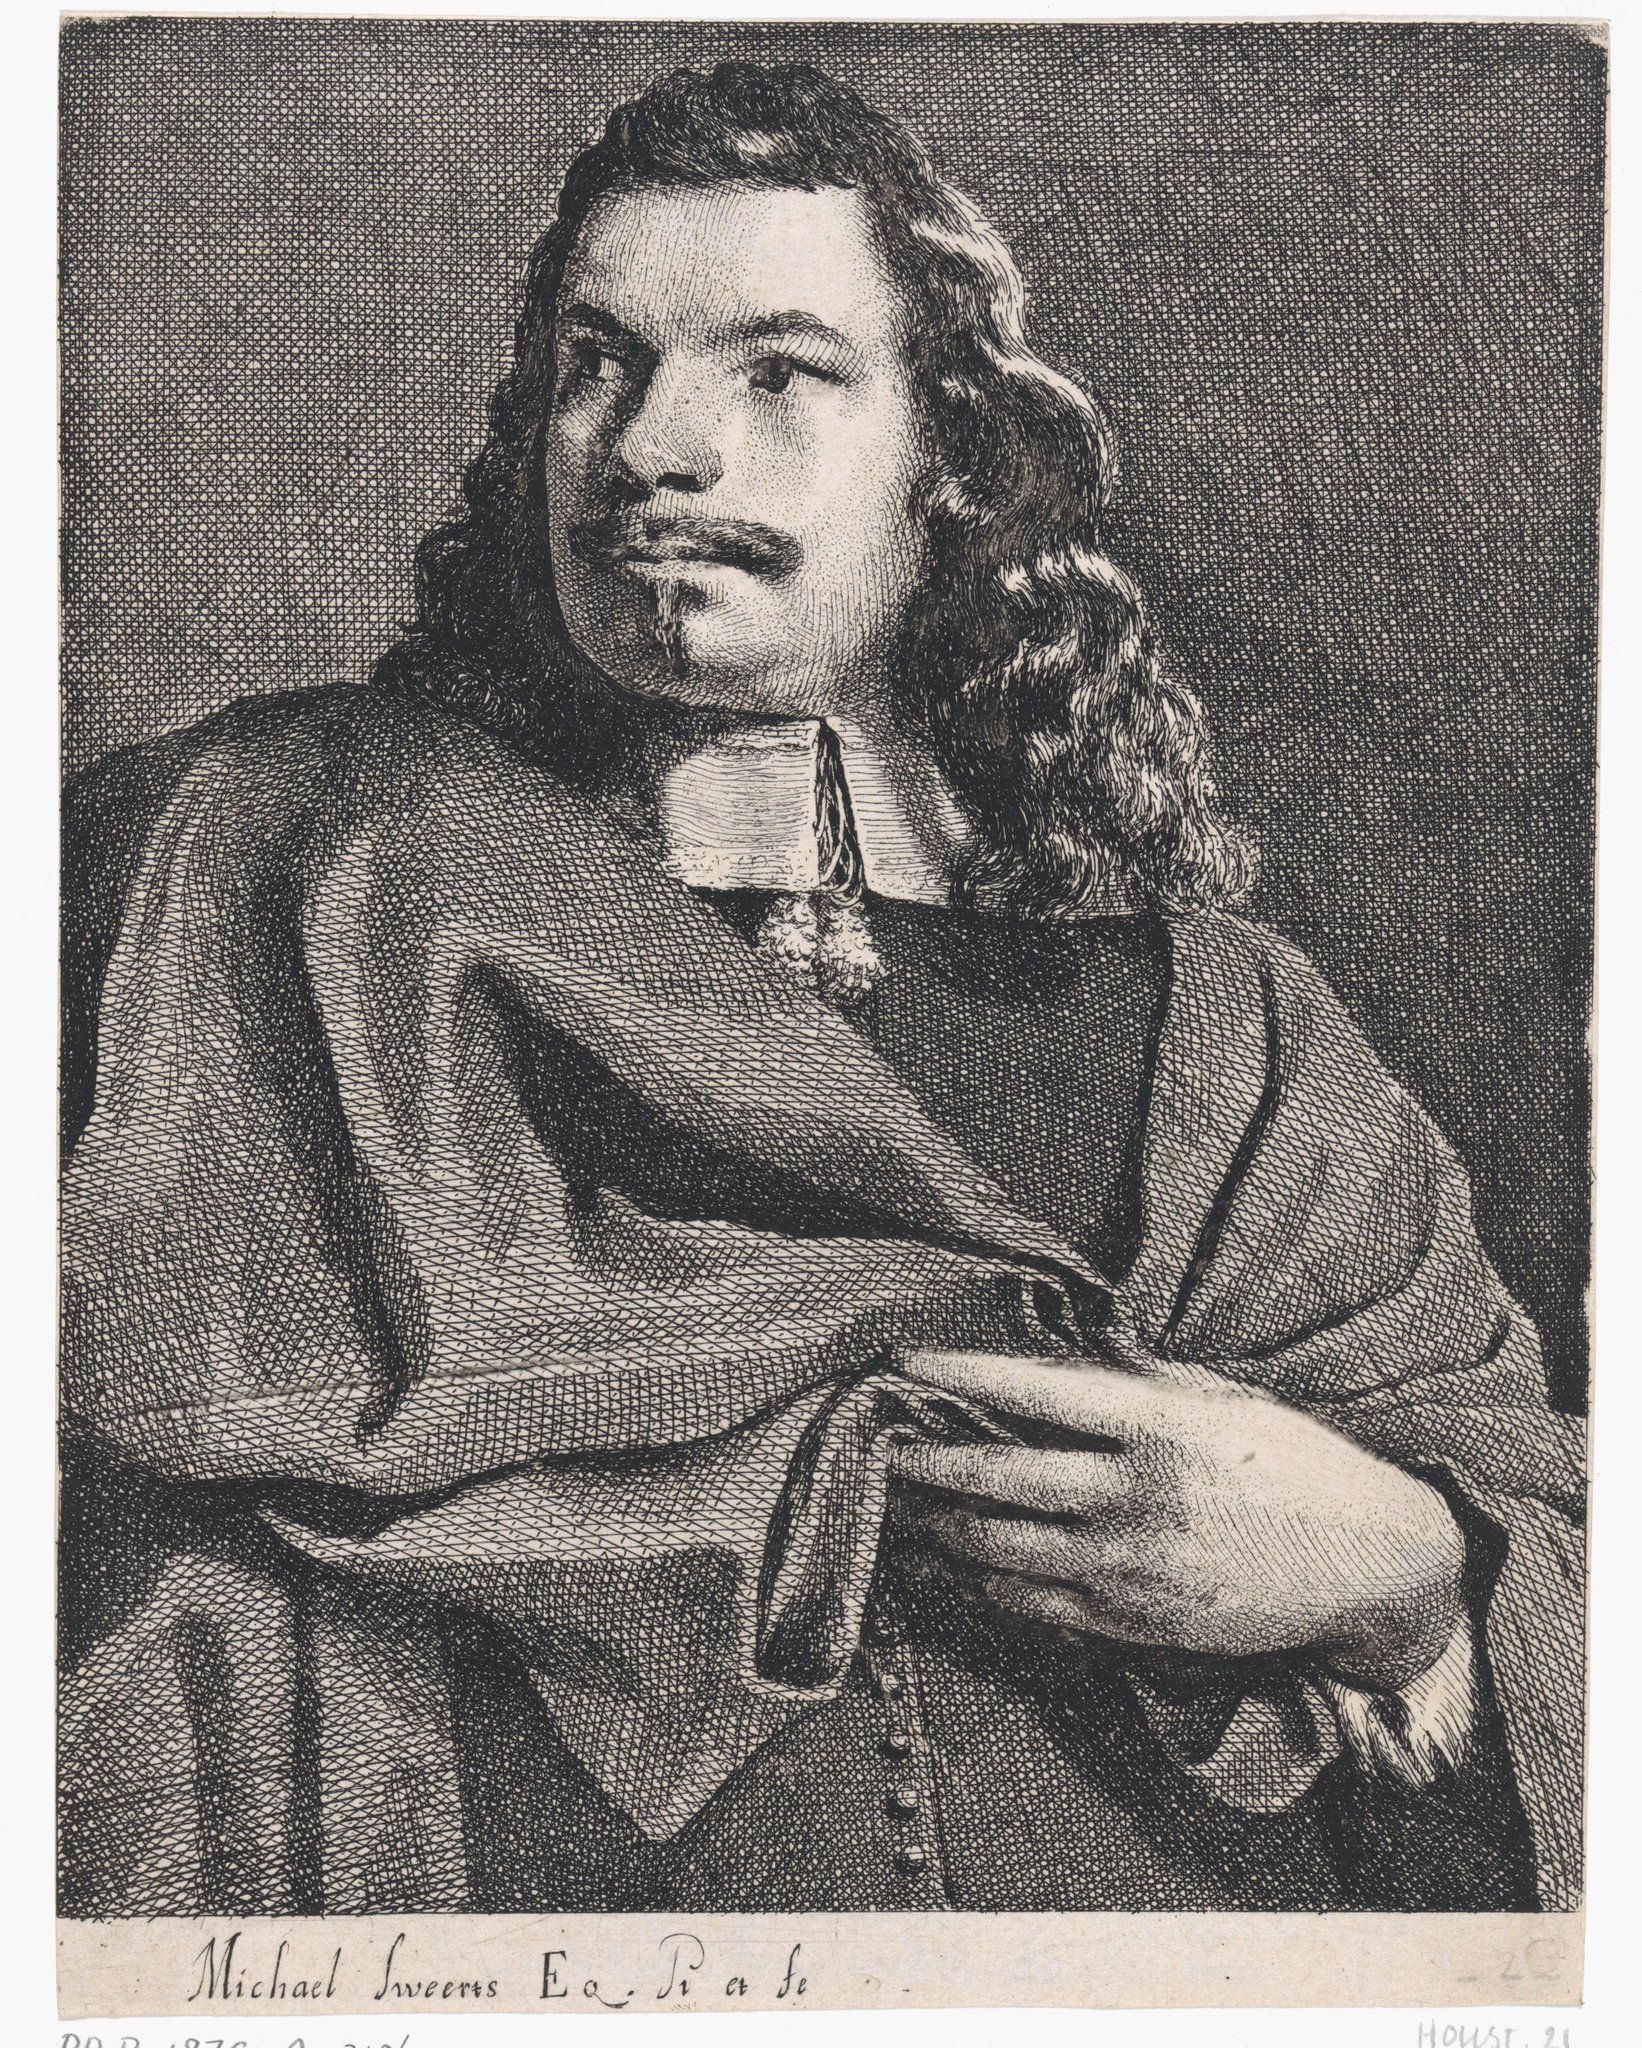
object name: print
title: Portret van een man in een mantel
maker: michael sweerts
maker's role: painter, print maker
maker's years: 1618-1664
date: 1643-1661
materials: paper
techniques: etching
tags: anonymous historical person portrayed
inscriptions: inscription: ‘zelf. I. v. Bronkhorst of H. Saftleven’, collector's mark: Lugt 2228, number: ‘NAI 45’, collector's mark: Lugt 2610